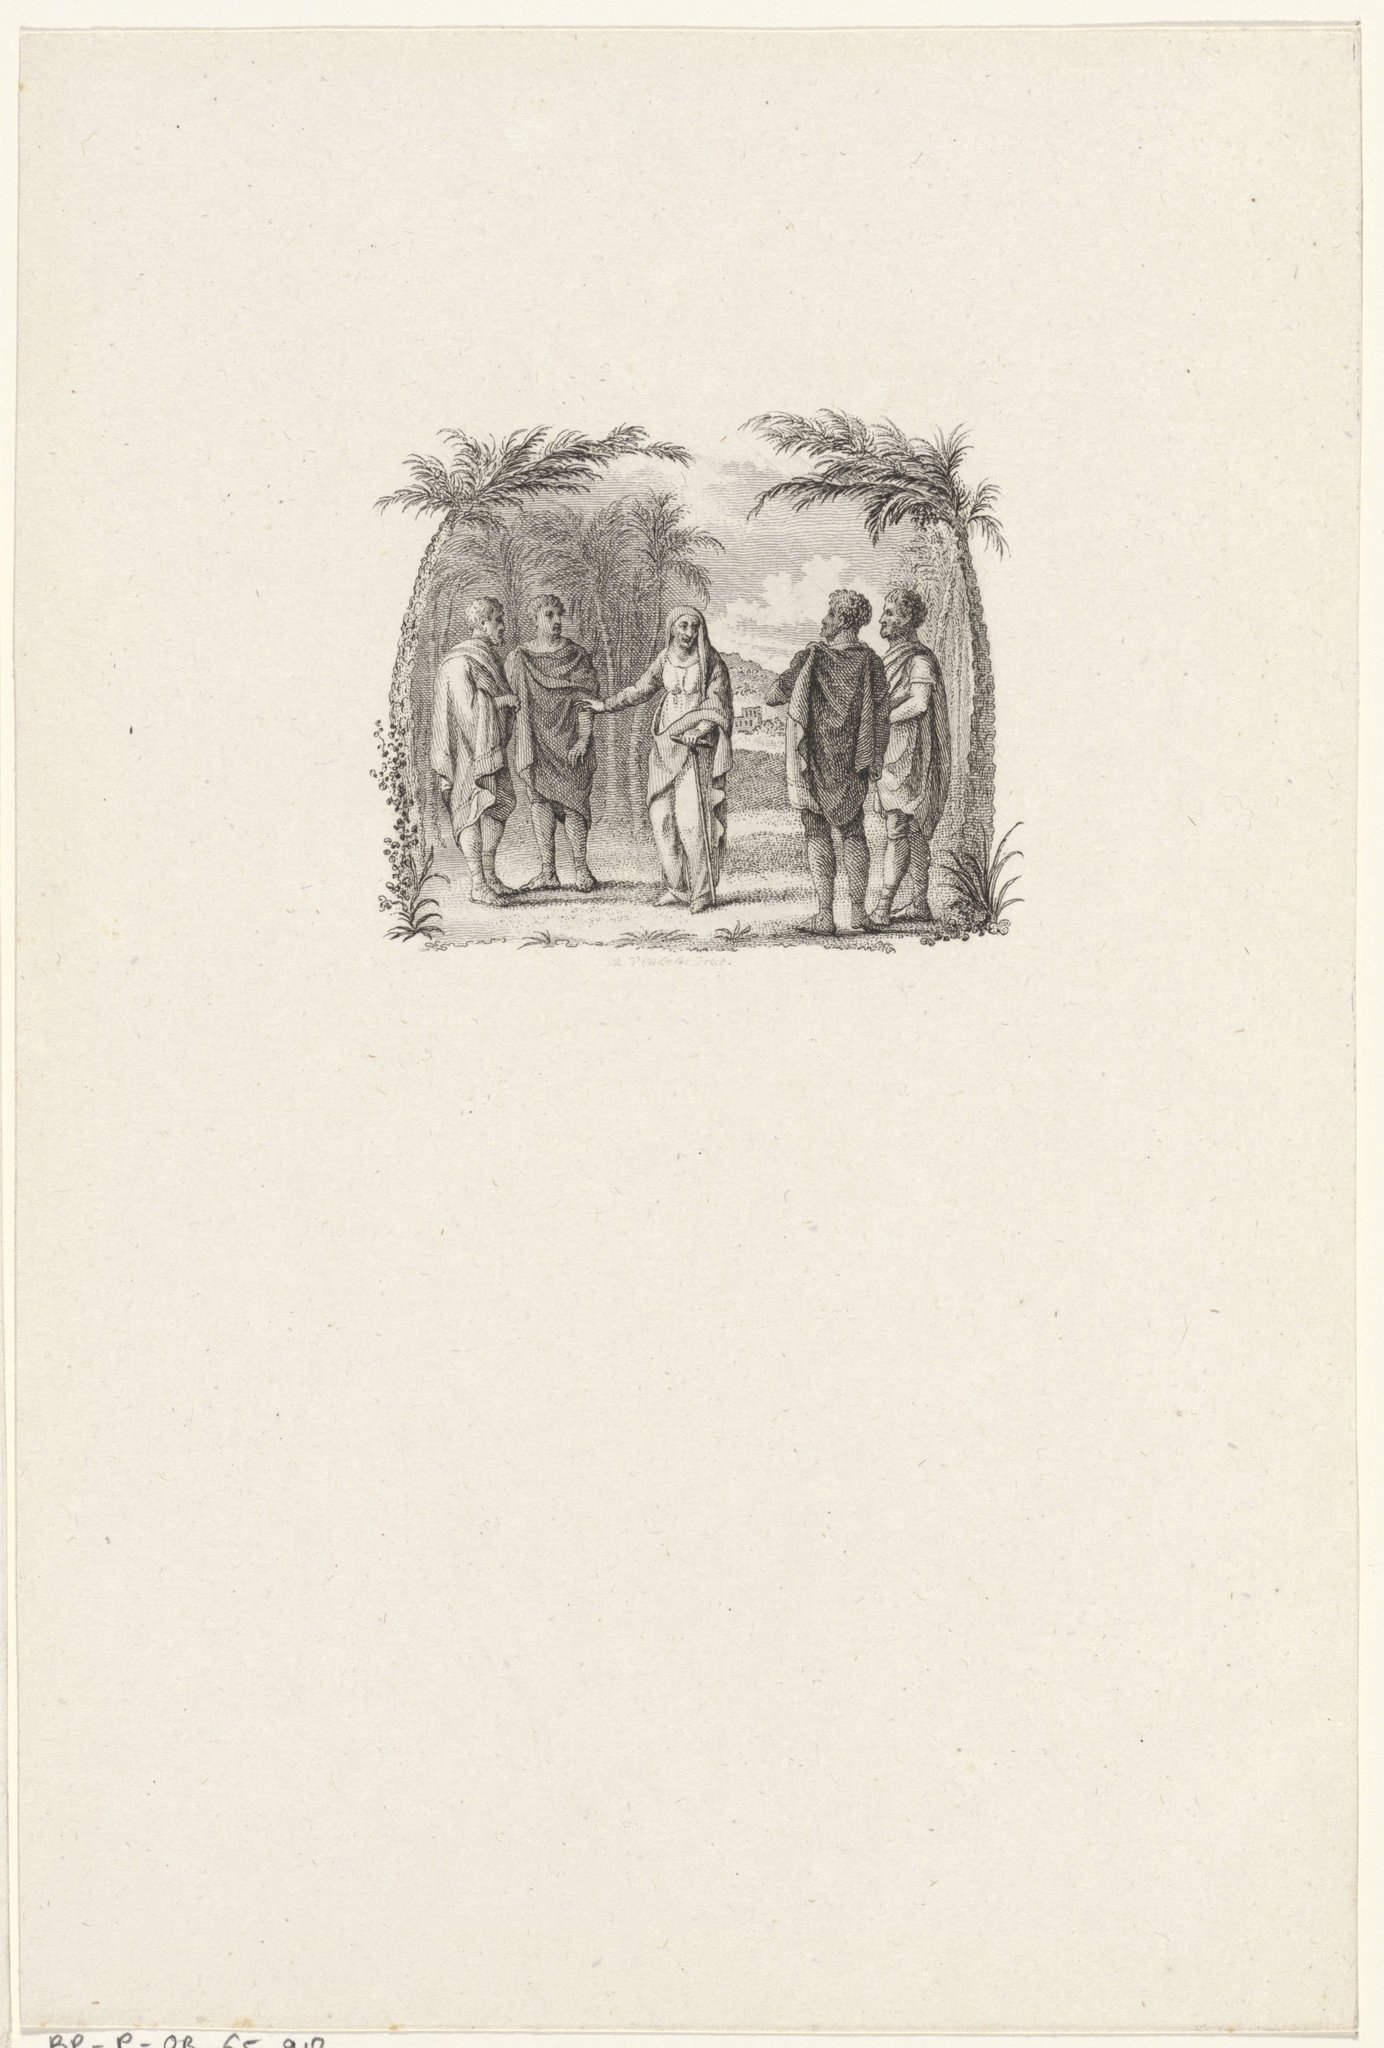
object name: print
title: Vier mannen en een oude vrouw tussen de palmbomen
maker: reinier vinkeles (i)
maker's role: draughtsman, print maker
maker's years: 1741-1816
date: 1751-1816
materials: paper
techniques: engraving, etching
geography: amsterdam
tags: trees: palm-tree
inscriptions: collector's mark: Lugt 2228